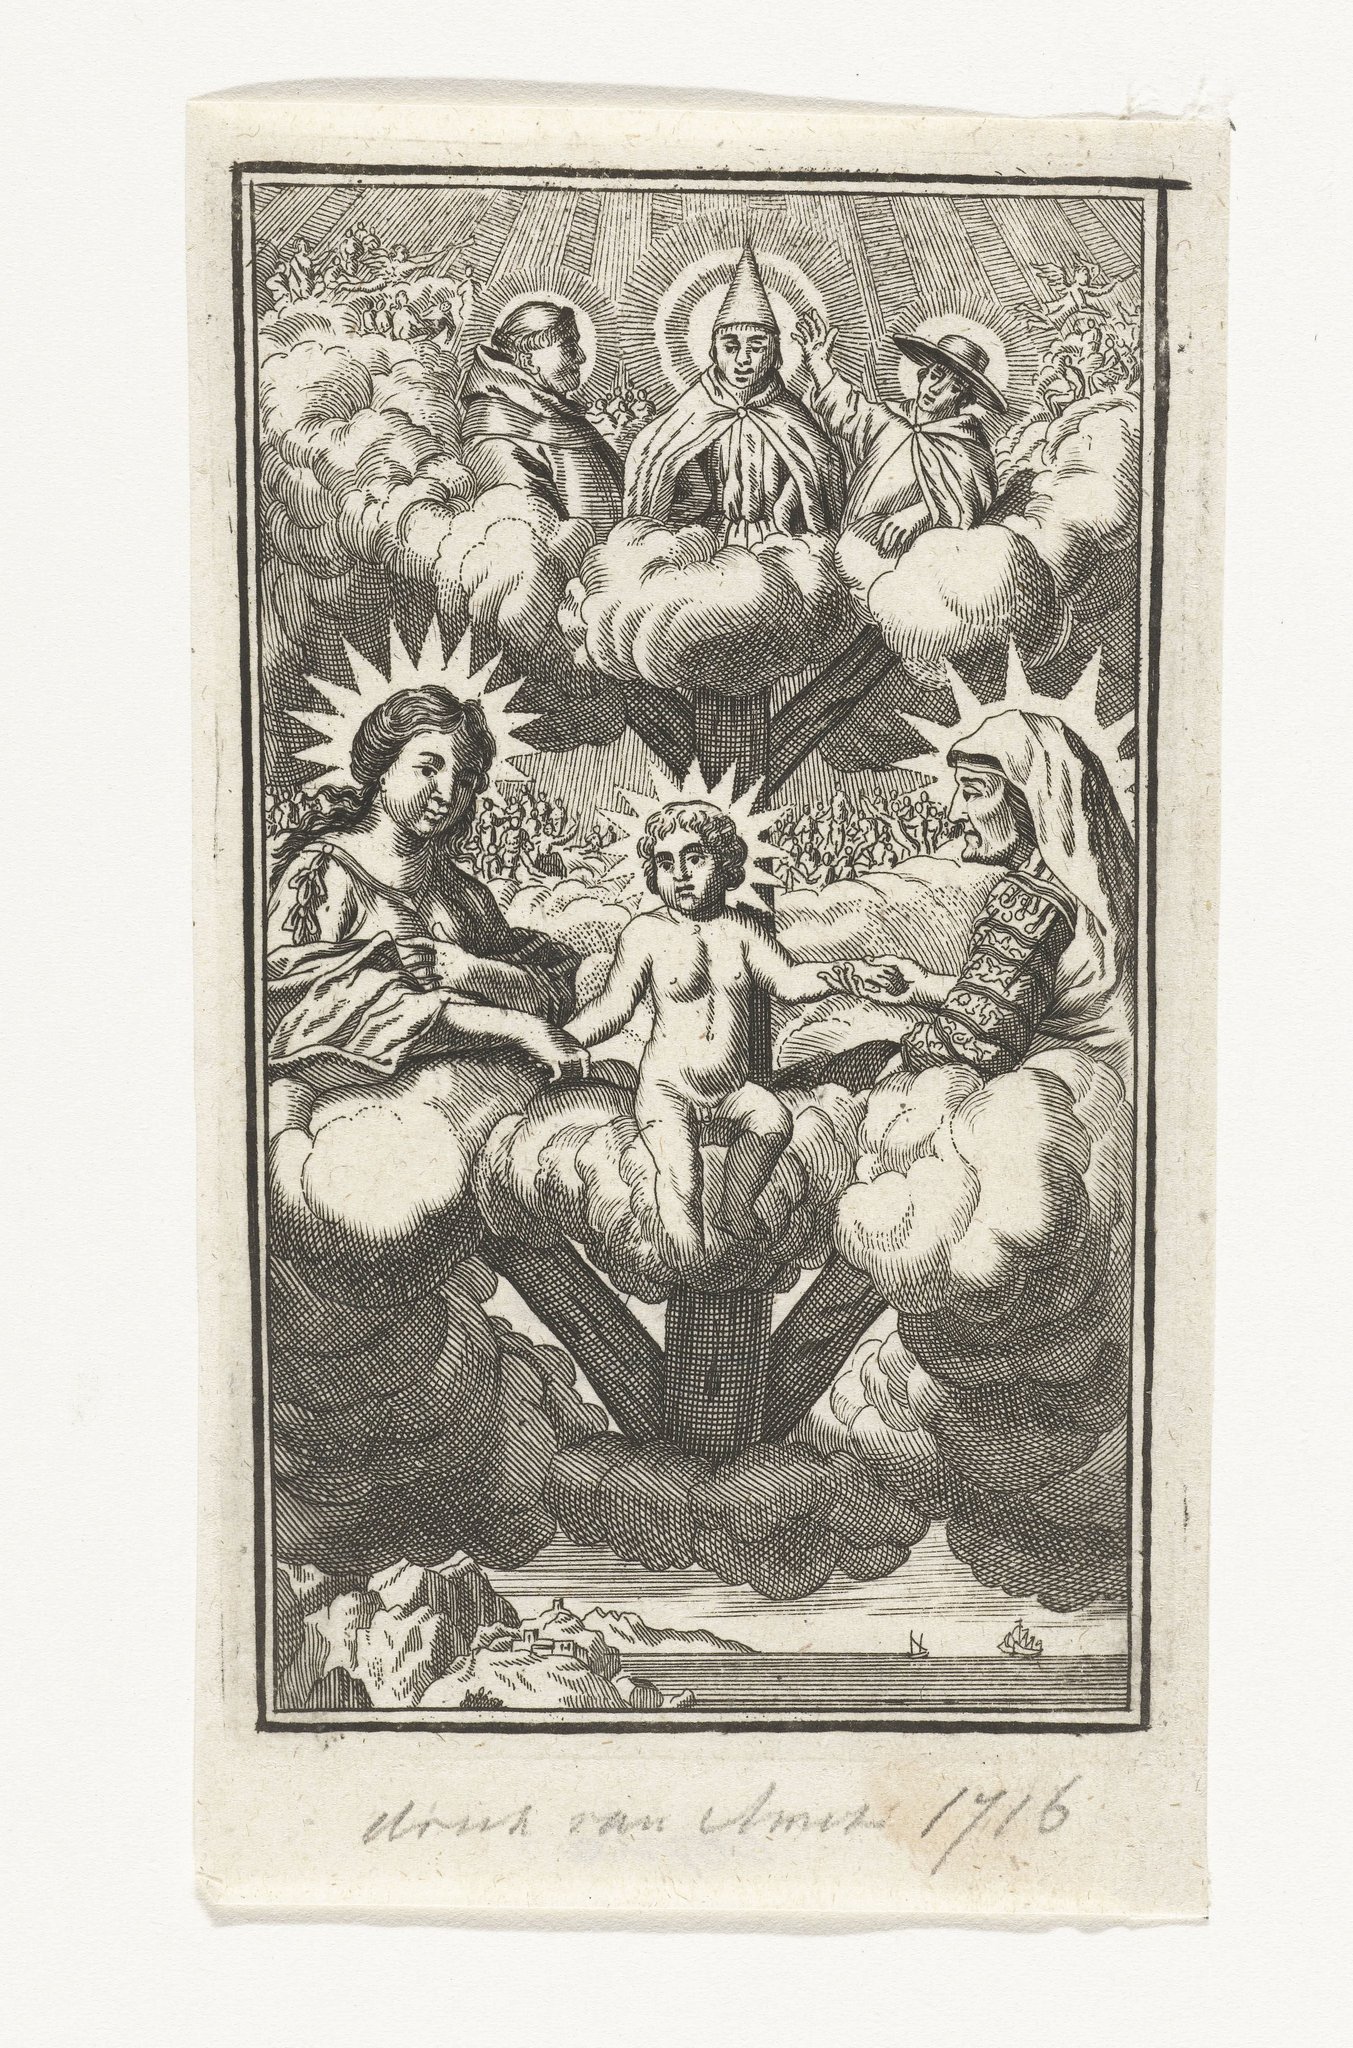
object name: print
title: Anna te Drieën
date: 1671-1716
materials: paper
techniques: engraving, etching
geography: amsterdam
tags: 'anna selbdritt', i.e. anna, mary and christ-child close together, the holy trinity, 'trinitas coelestis'; father, son and holy ghost ~ christian religion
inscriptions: collector's mark: Lugt 2228a, inscription: ‘druk van Amst 1716’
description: Maria, het Christuskind en Anna in de wolken met boven hen de Drie-eenheid gerepresenteerd als een monnik, een abt en een kardinaal. Kopie in spiegelbeeld.